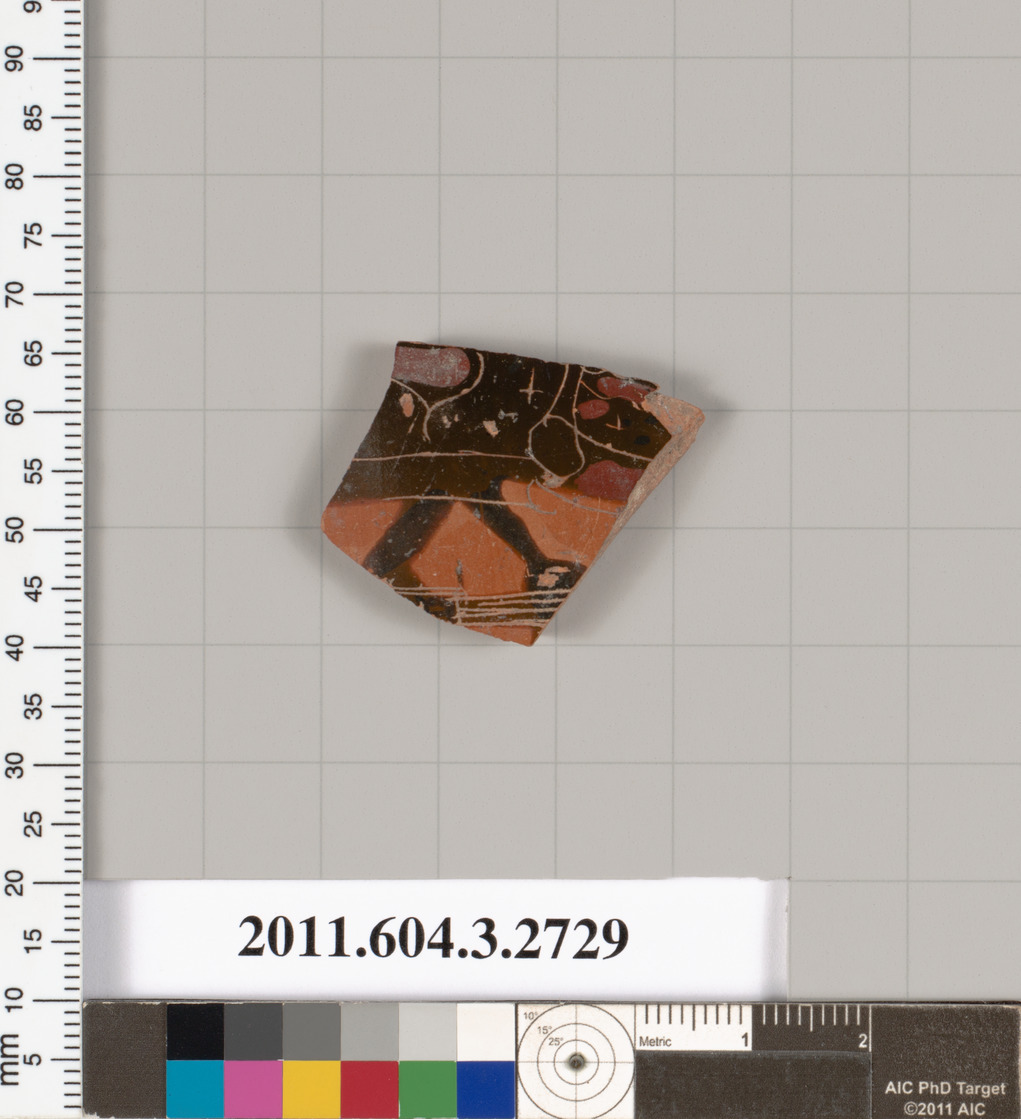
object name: oinochoe fragment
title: Terracotta fragment of an oinochoe (jug)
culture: greek, attic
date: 534-468 BCE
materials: terracotta